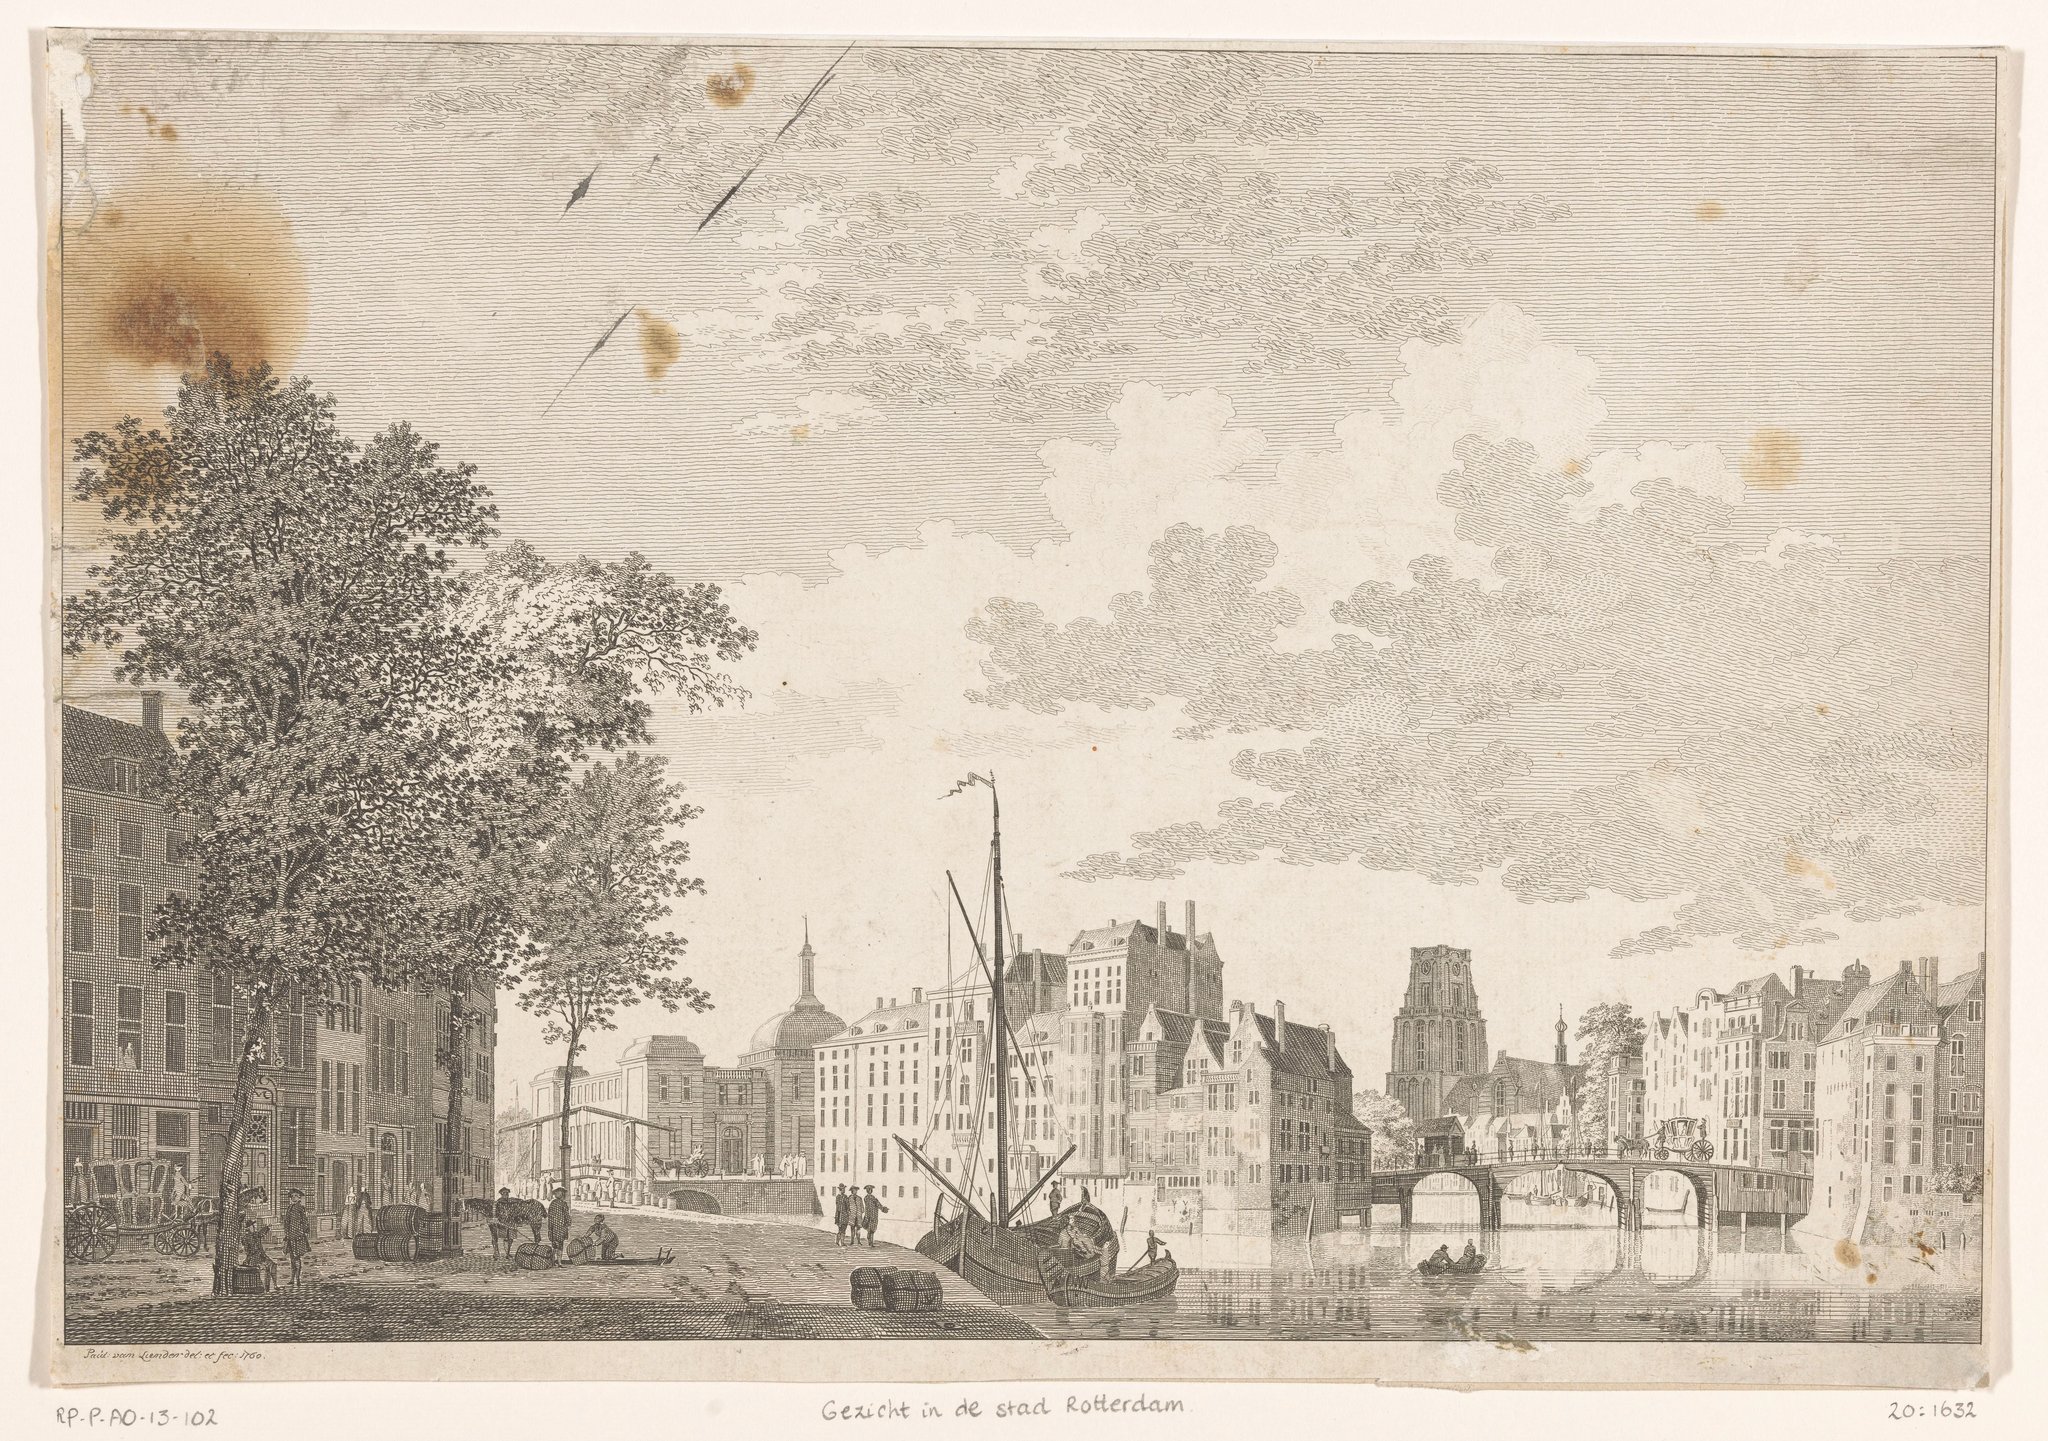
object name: print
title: Gezicht bij de Oudehaven te Rotterdam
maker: paulus van liender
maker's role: draughtsman, print maker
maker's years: 1731-1797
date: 1760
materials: paper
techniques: etching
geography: utrecht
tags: harbour, bridge in city across river, canal, etc. (+ city(-scape) with figures, staffage), stock exchange, stock-market, church (exterior), street (+ city(-scape) with figures, staffage)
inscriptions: collector's mark: Lugt 2233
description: Gezicht bij de Oudehaven te Rotterdam. Links de Geldersekade. Op de achtergrond links de Beurs aan de Blaak. Op de achtergrond rechts de Grote of Sint-Laurenskerk.